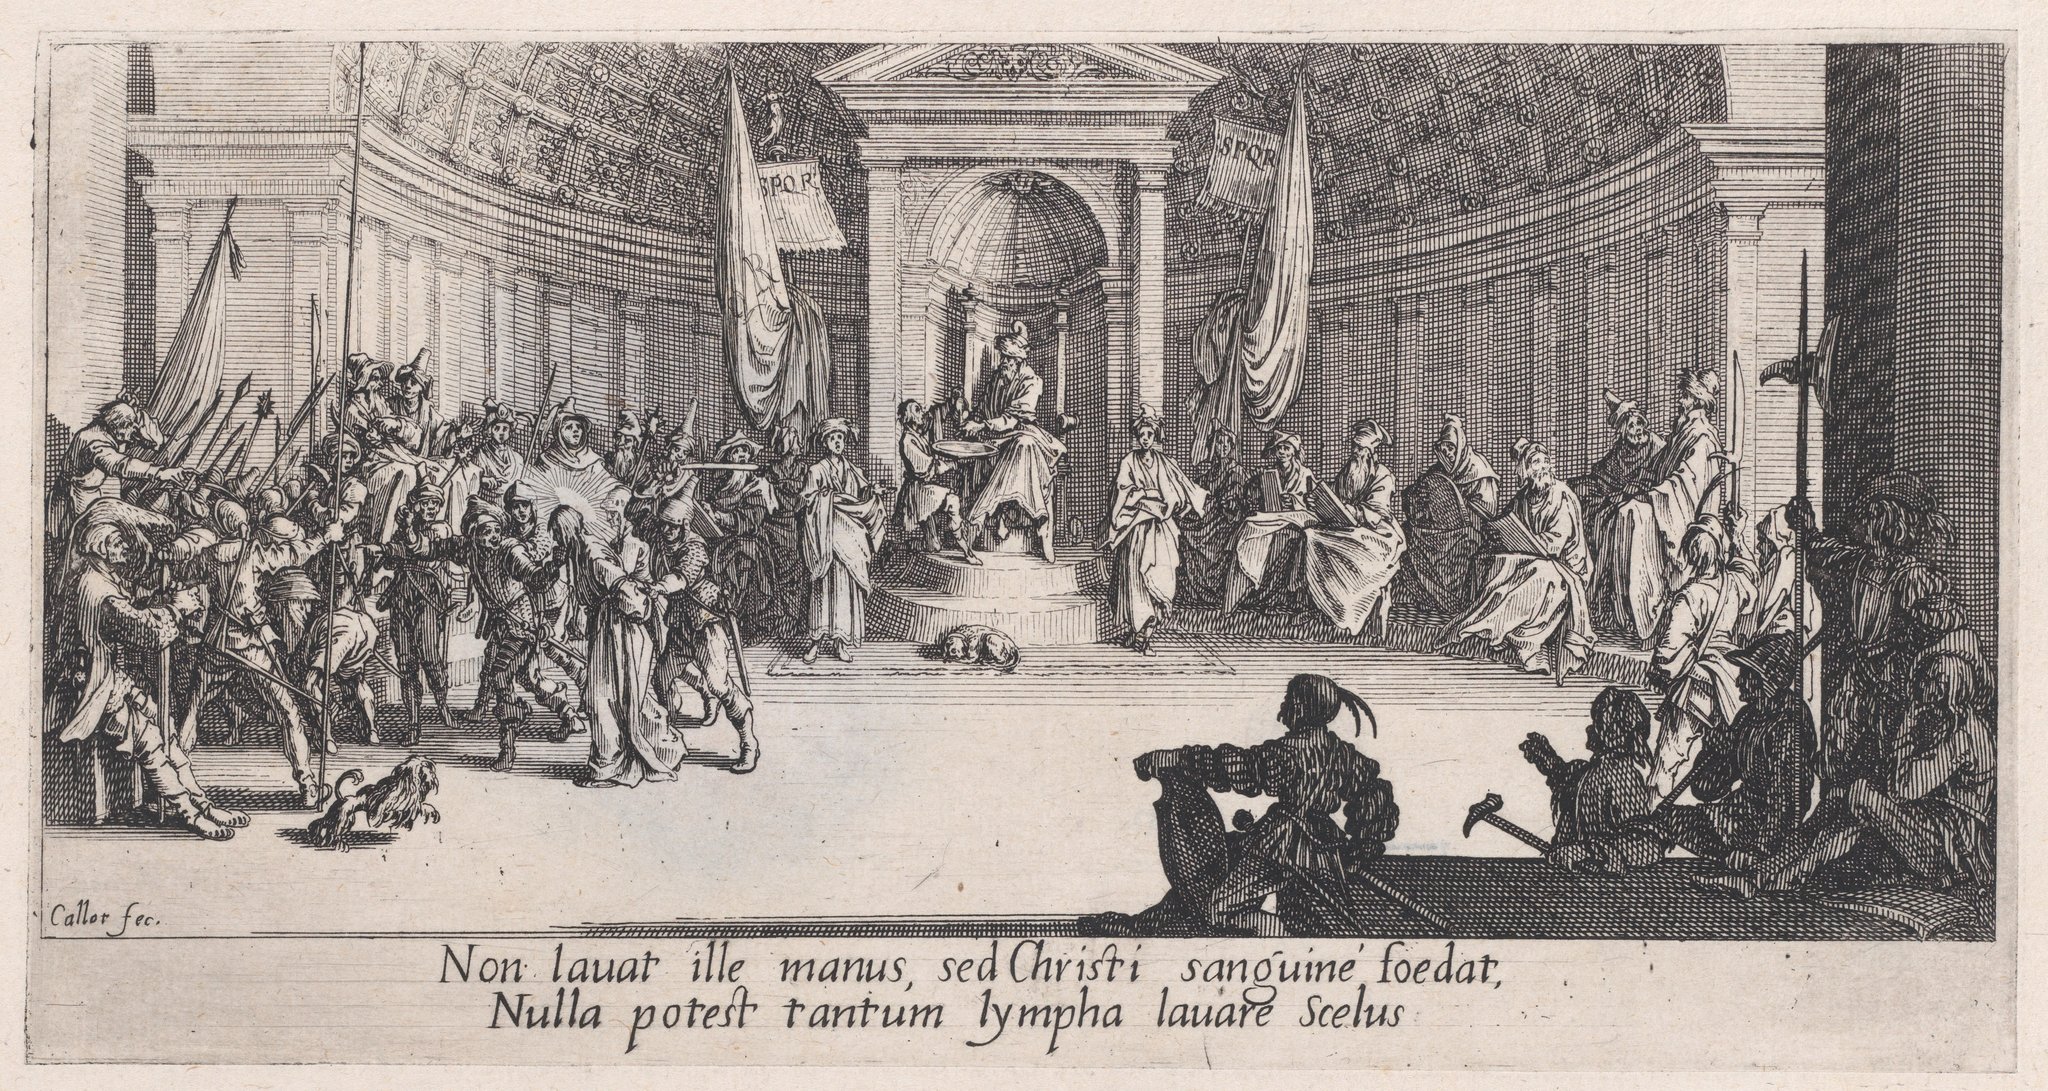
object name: print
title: La Condamnation a Mort (The Condemnation to Death), from "La Grande Passion" (The Large Passion)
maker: jacques callot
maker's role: artist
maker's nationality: french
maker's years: 1592-1635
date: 1619-1624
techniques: engraving, etching